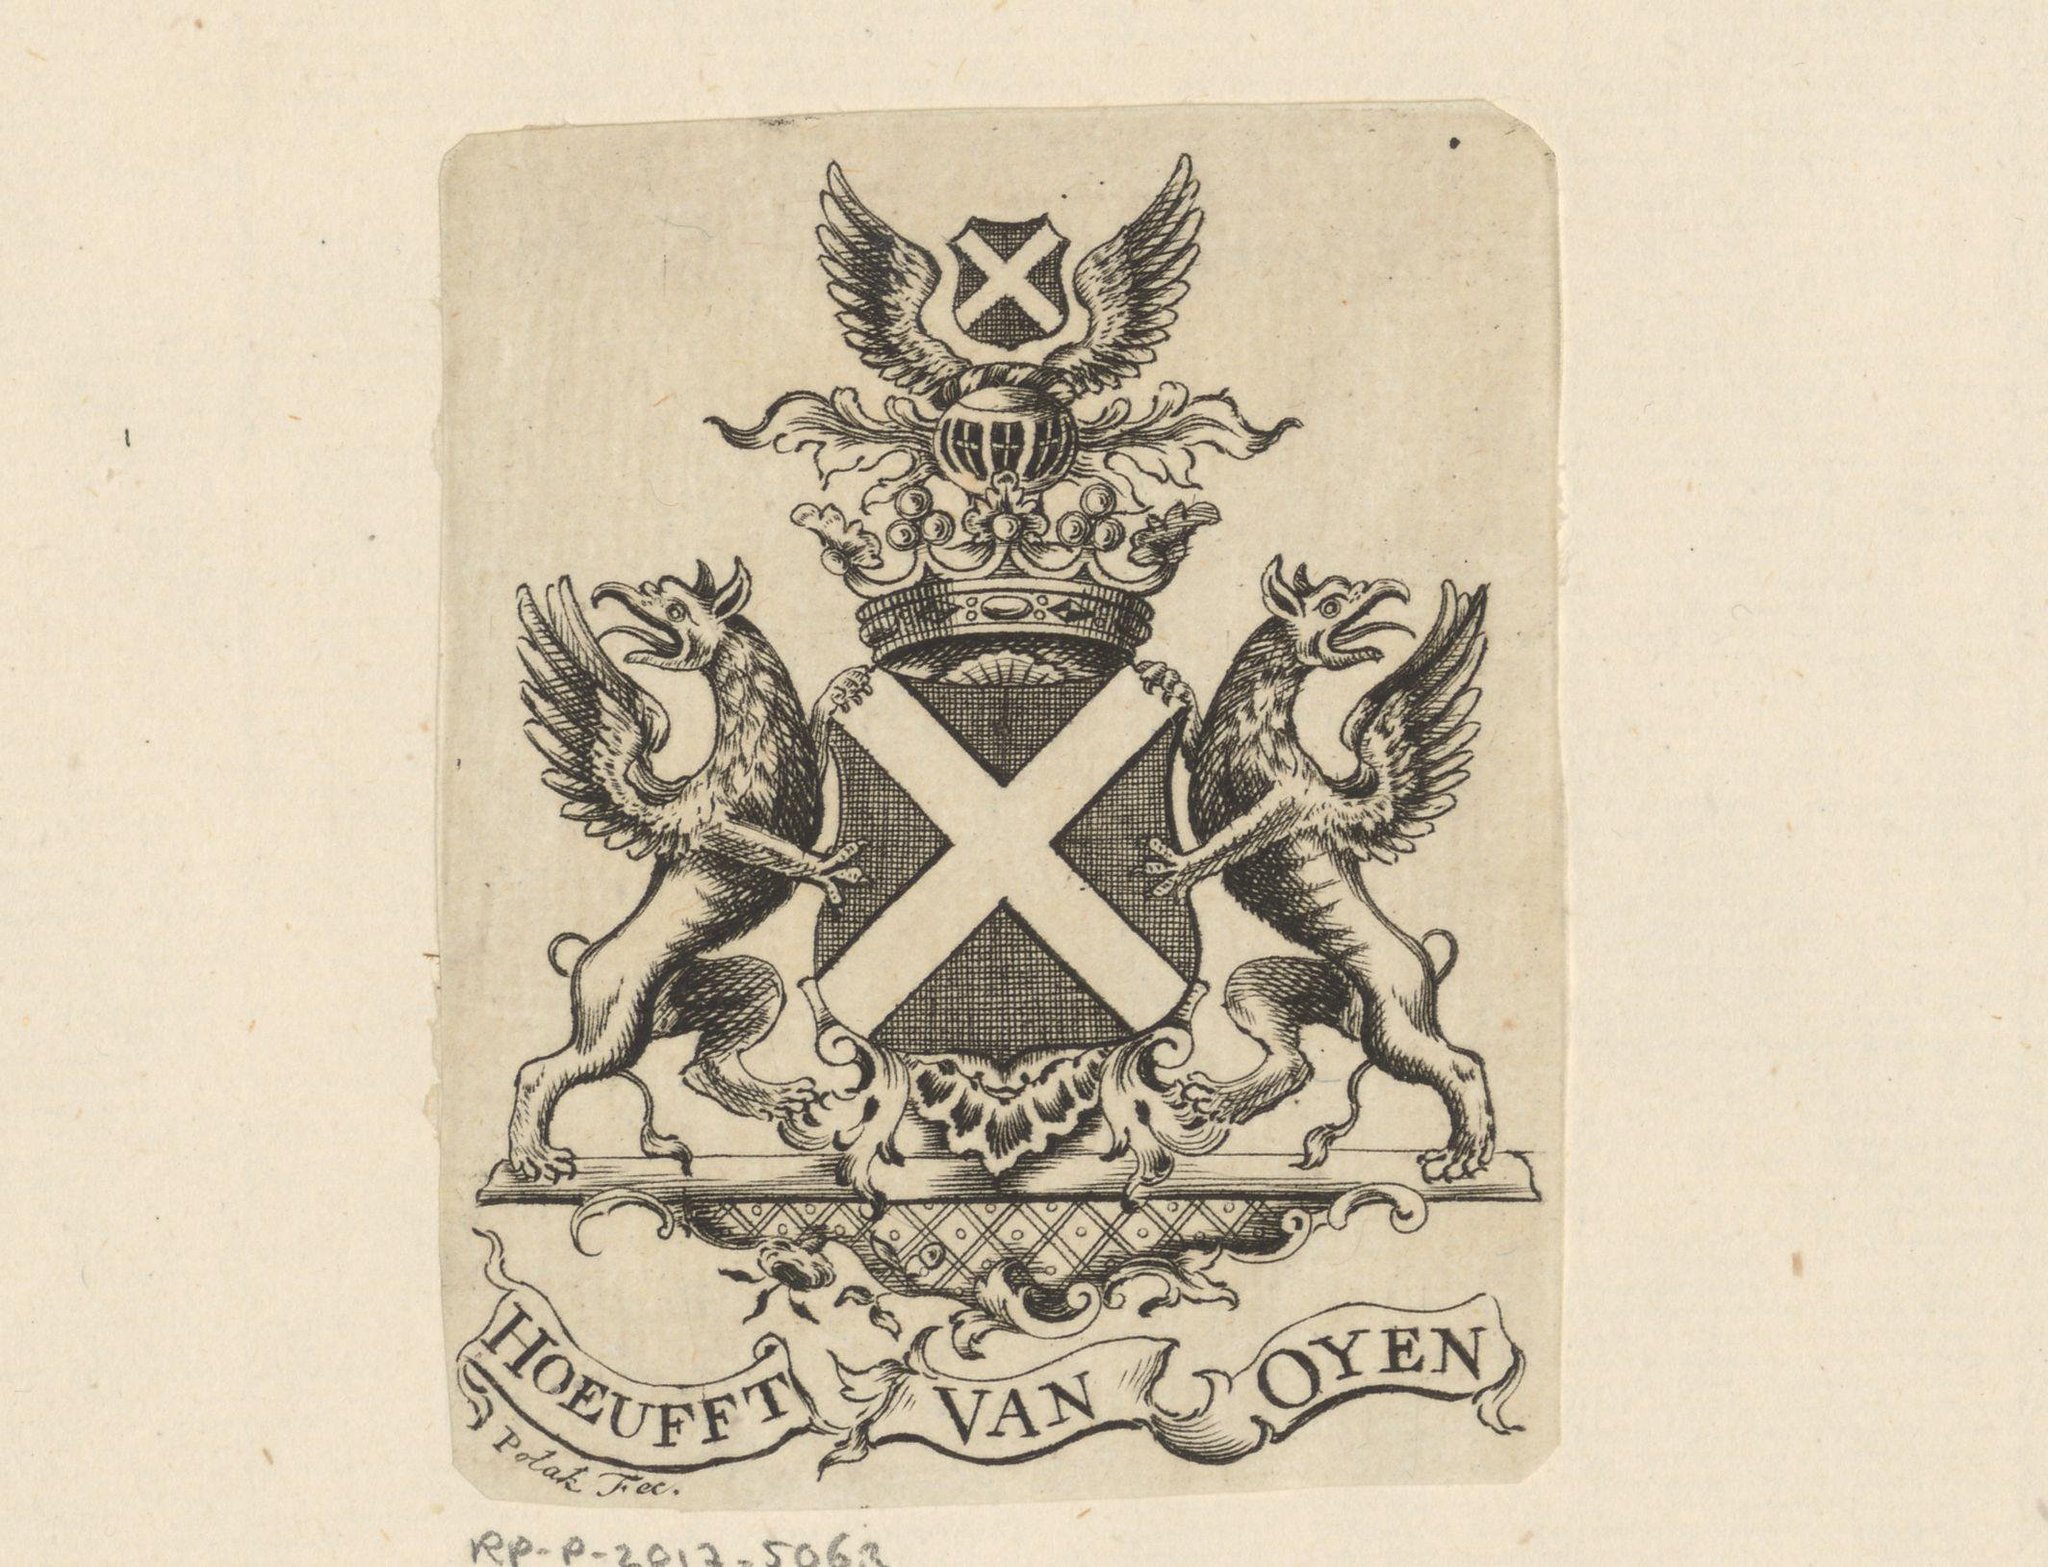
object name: bookplate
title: Ex libris van Hoeufft van Oyen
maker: abraham isack polak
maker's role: print maker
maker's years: 1720-1790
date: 1730-1790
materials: paper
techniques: etching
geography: netherlands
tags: griffin (lion/eagle); 'griffo' (ripa), armorial bearing, heraldry